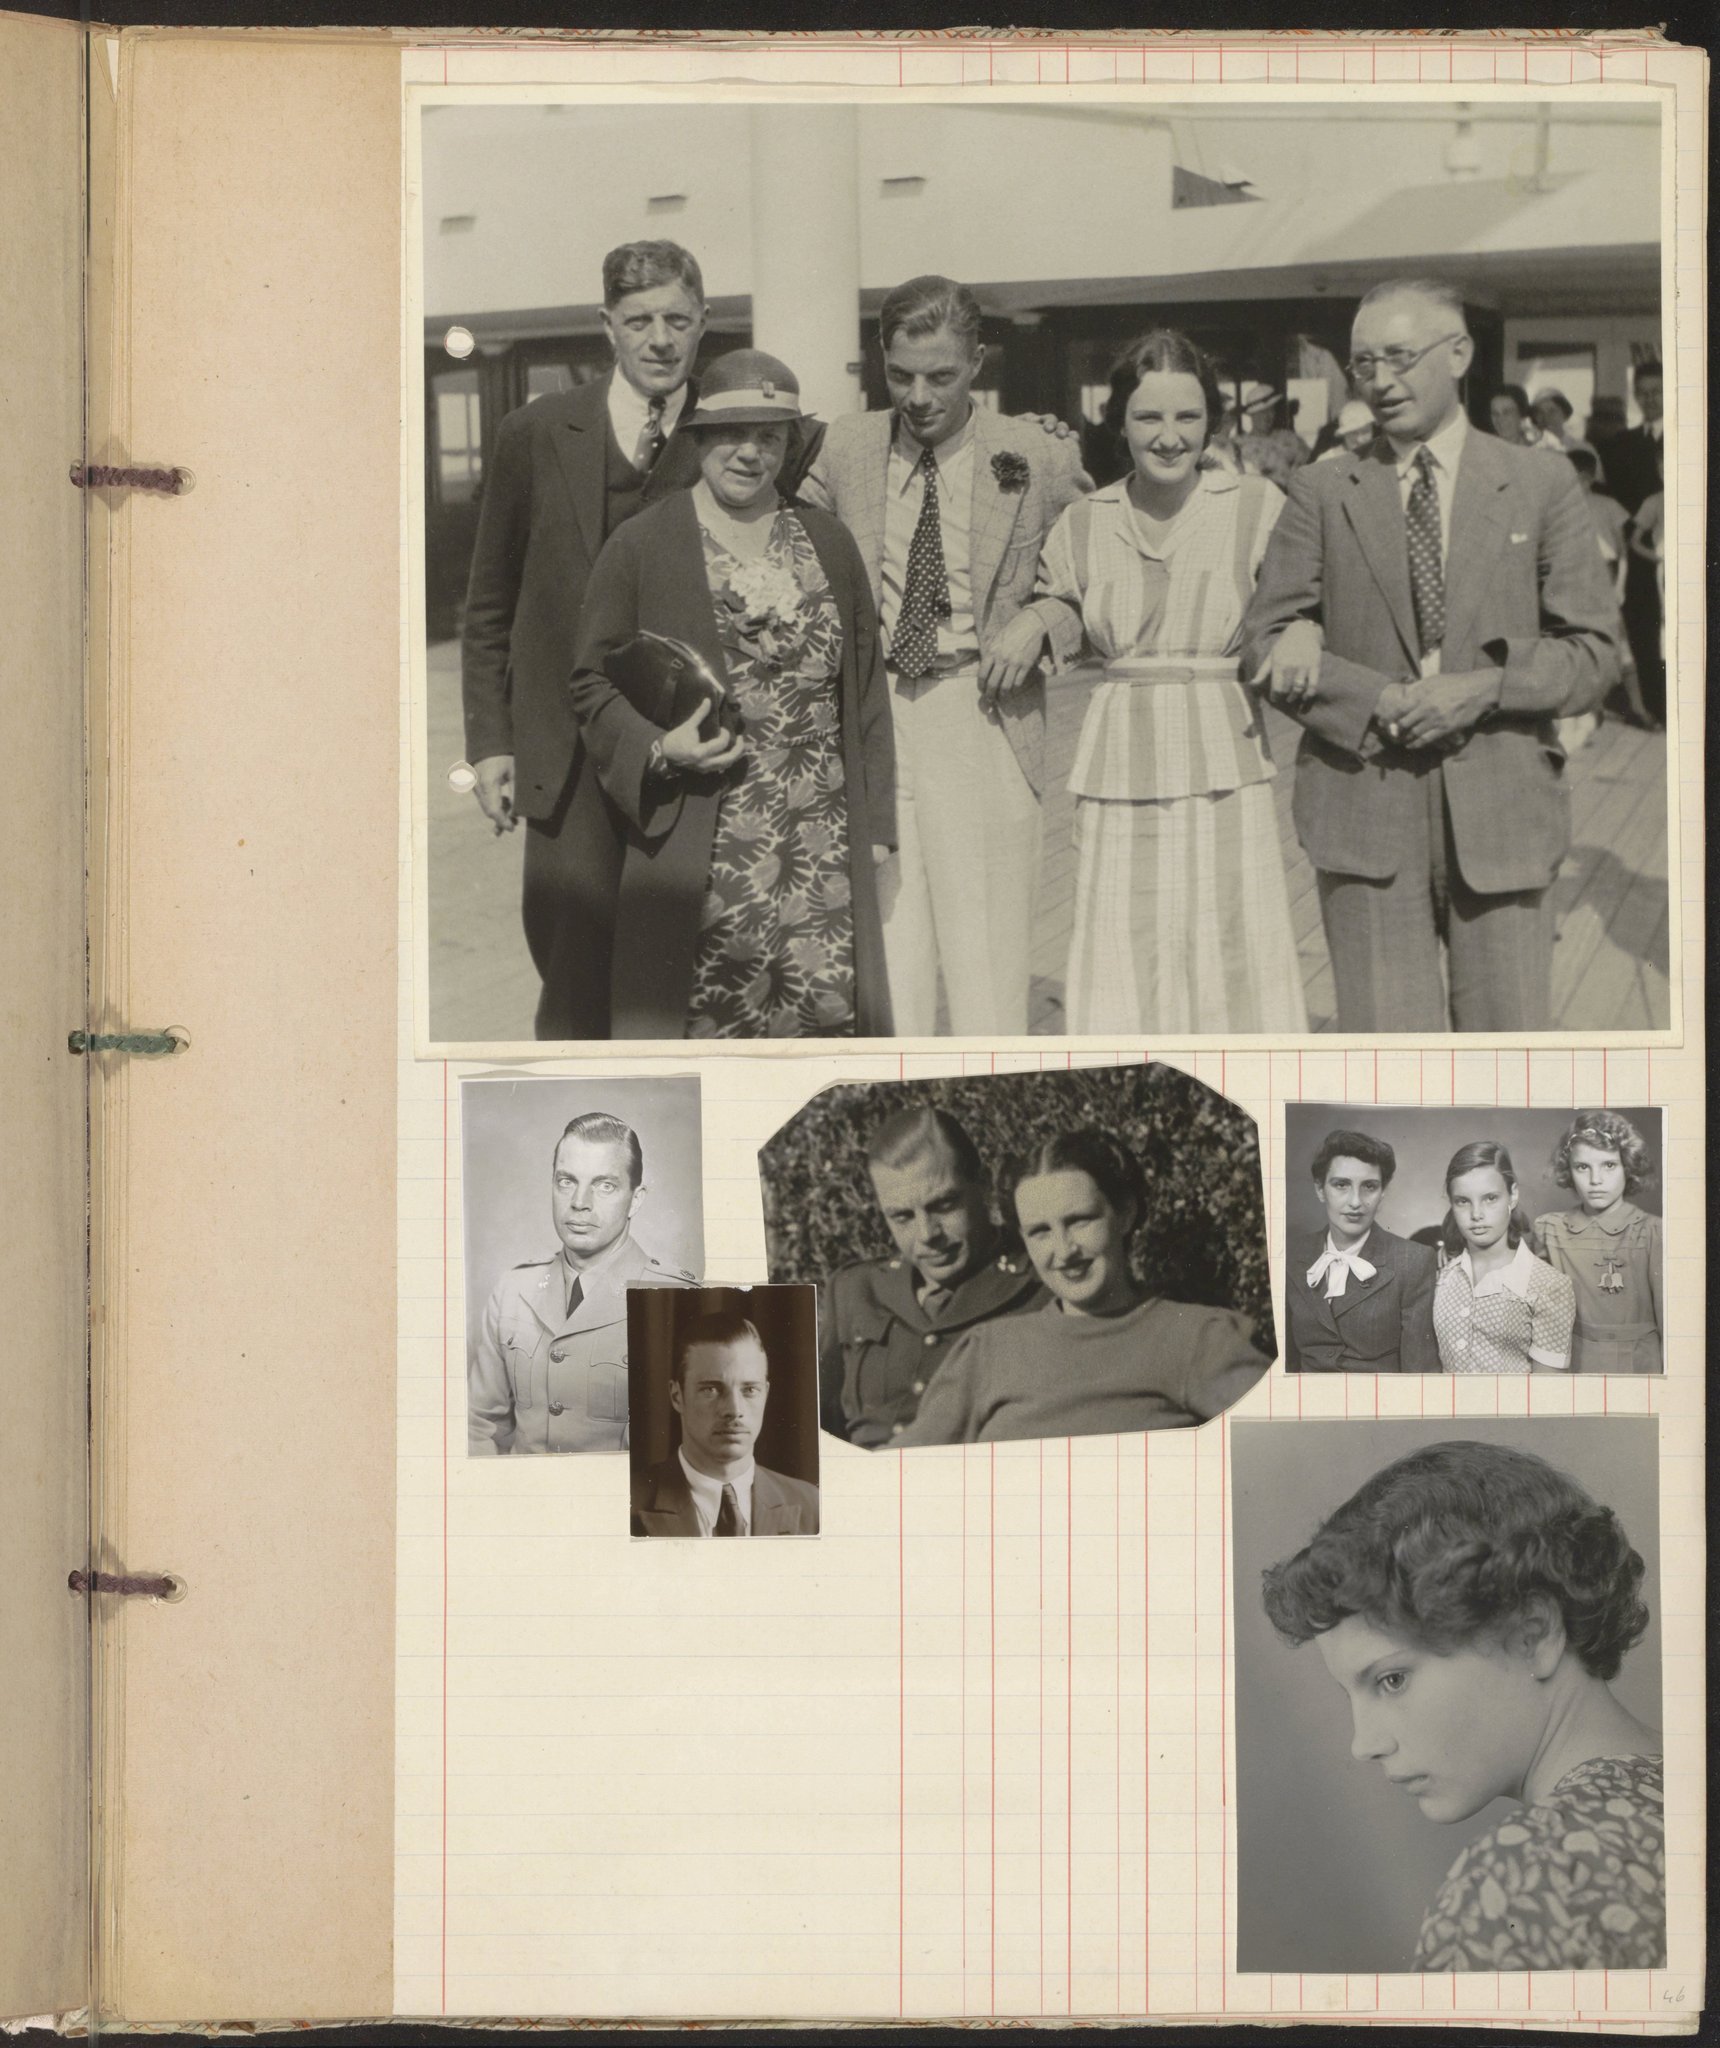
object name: album leaf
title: Portretten van onbekende personen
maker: Anonymous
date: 1920-1940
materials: paper, photographic support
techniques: gelatin silver print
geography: netherlands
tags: adolescent, young woman, maiden, adult woman, adult man, child, (military) uniforms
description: Albumblad met portretten van volwassenen, waaronder een man in militair tenue, en van jonge meisjes. Onderdeel van Fotoalbum van de familie Petri.